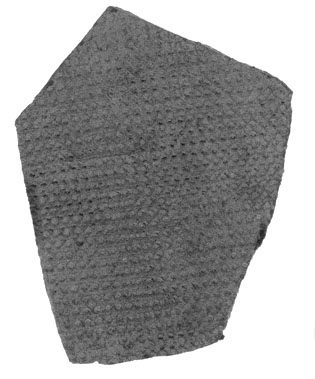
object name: fragment of a jar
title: Fragment of a Jar (Study Collection)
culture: chinese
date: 1046-256 BCE